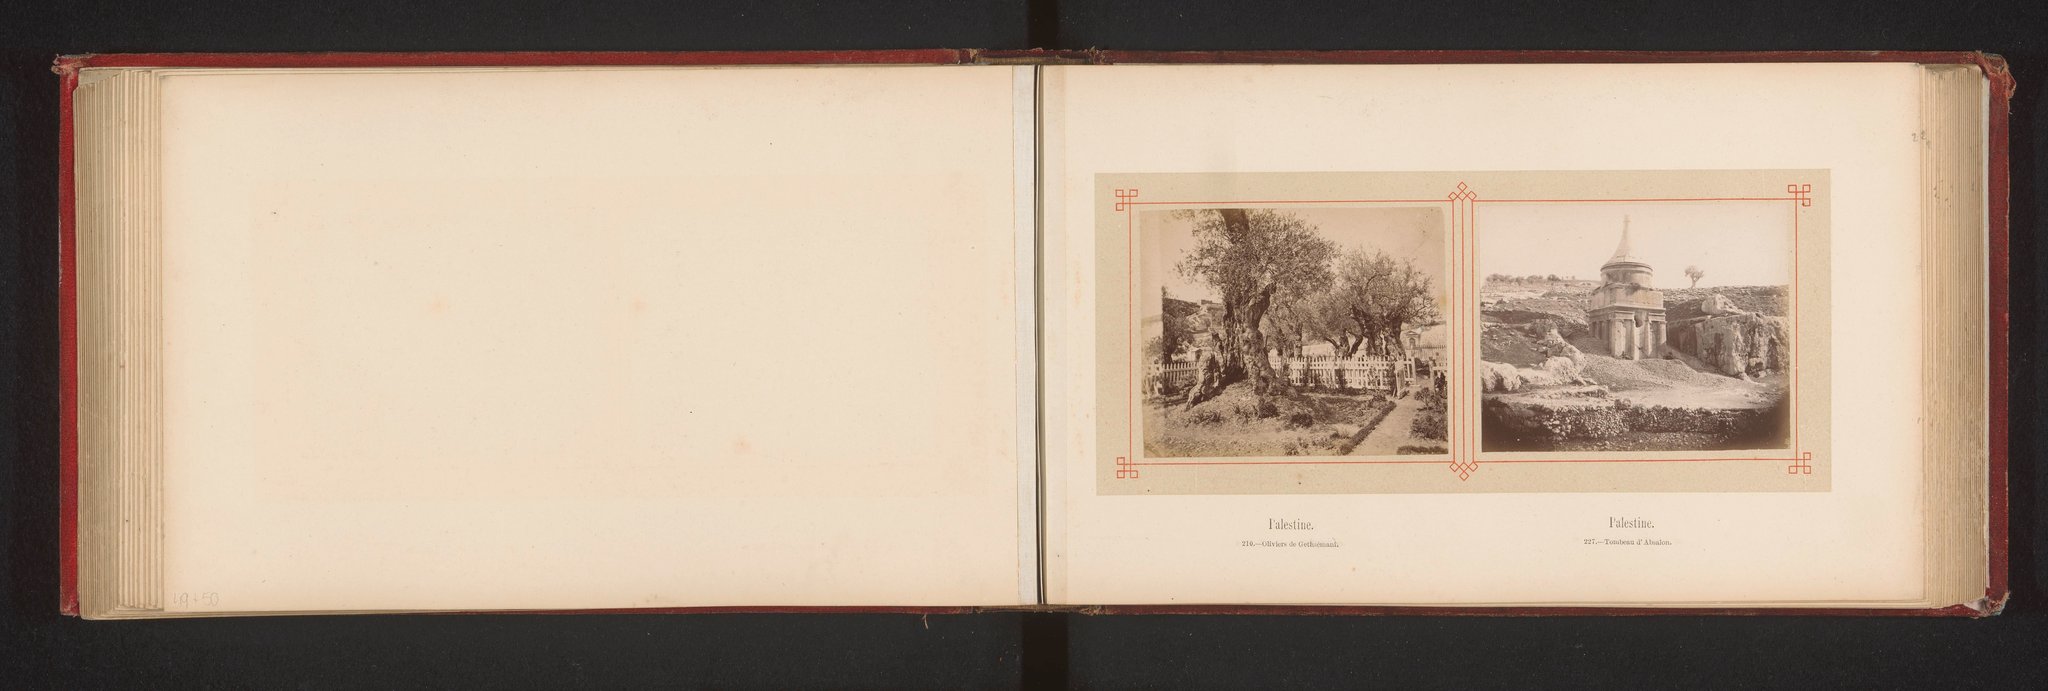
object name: photograph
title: Olijfbomen in de tuinen van Gethsemane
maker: félix bonfils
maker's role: fotograaf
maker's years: 1831-1885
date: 1873-1878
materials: photographic support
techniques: albumen print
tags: trees